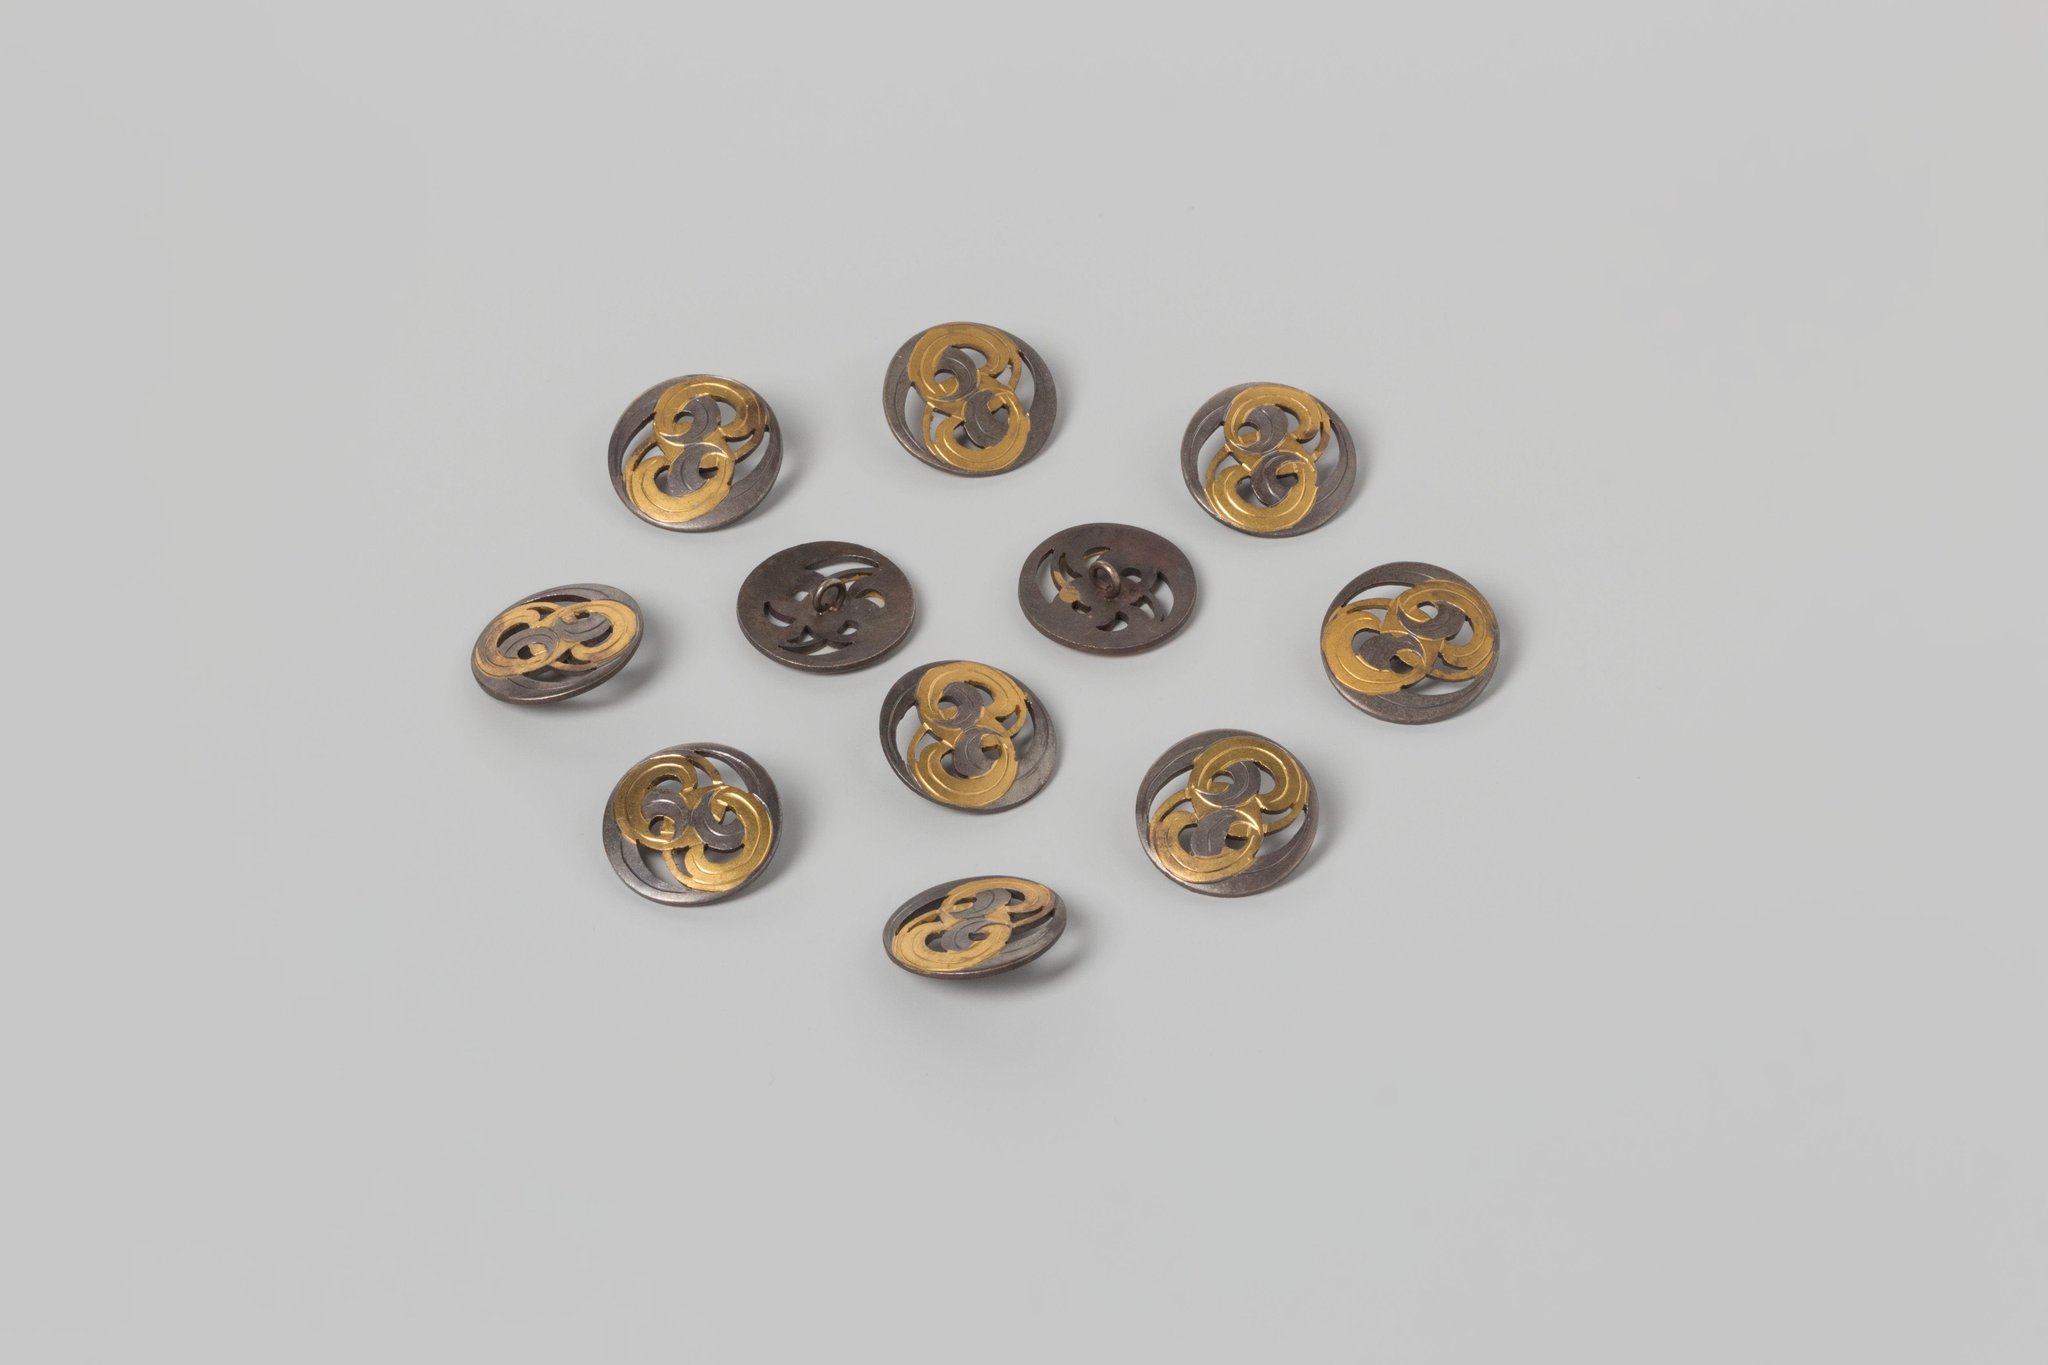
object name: button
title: Knoop, plat en rond, van gedeeltelijk met goudverf beschilderd metaal met krulmotief, opengewerkt en gegraveerd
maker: Anonymous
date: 1880-1940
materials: paint, metal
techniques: embroidery, engraving, painting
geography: europe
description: Knoop, plat en rond, van gedeeltelijk met goudverf beschilderd metaal met krulmotief, opengewerkt en gegraveerd, met oog aan de achterzijde.